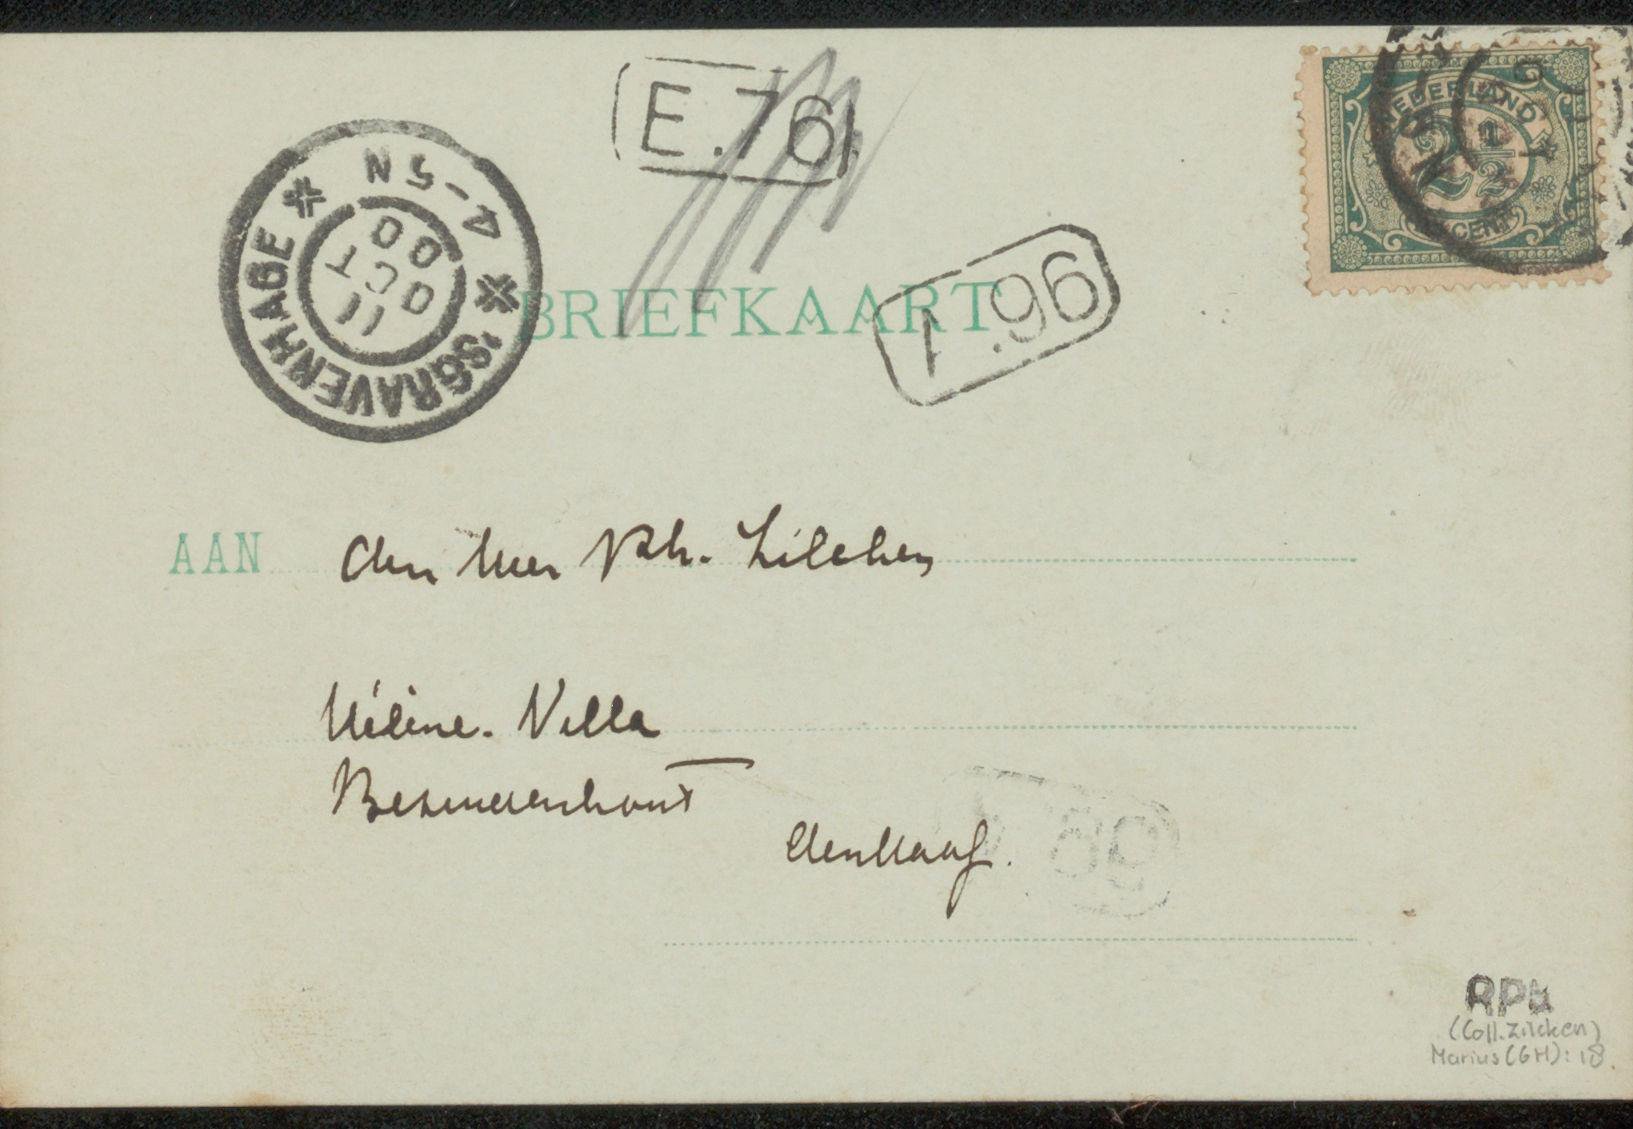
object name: postcard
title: Briefkaart aan Philip Zilcken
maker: grada hermina marius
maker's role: painter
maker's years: 1854-1919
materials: cardboard, ink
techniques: pen, writing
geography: the hague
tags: draughtsman, philip zilcken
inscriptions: collector's mark: ‘RPK’